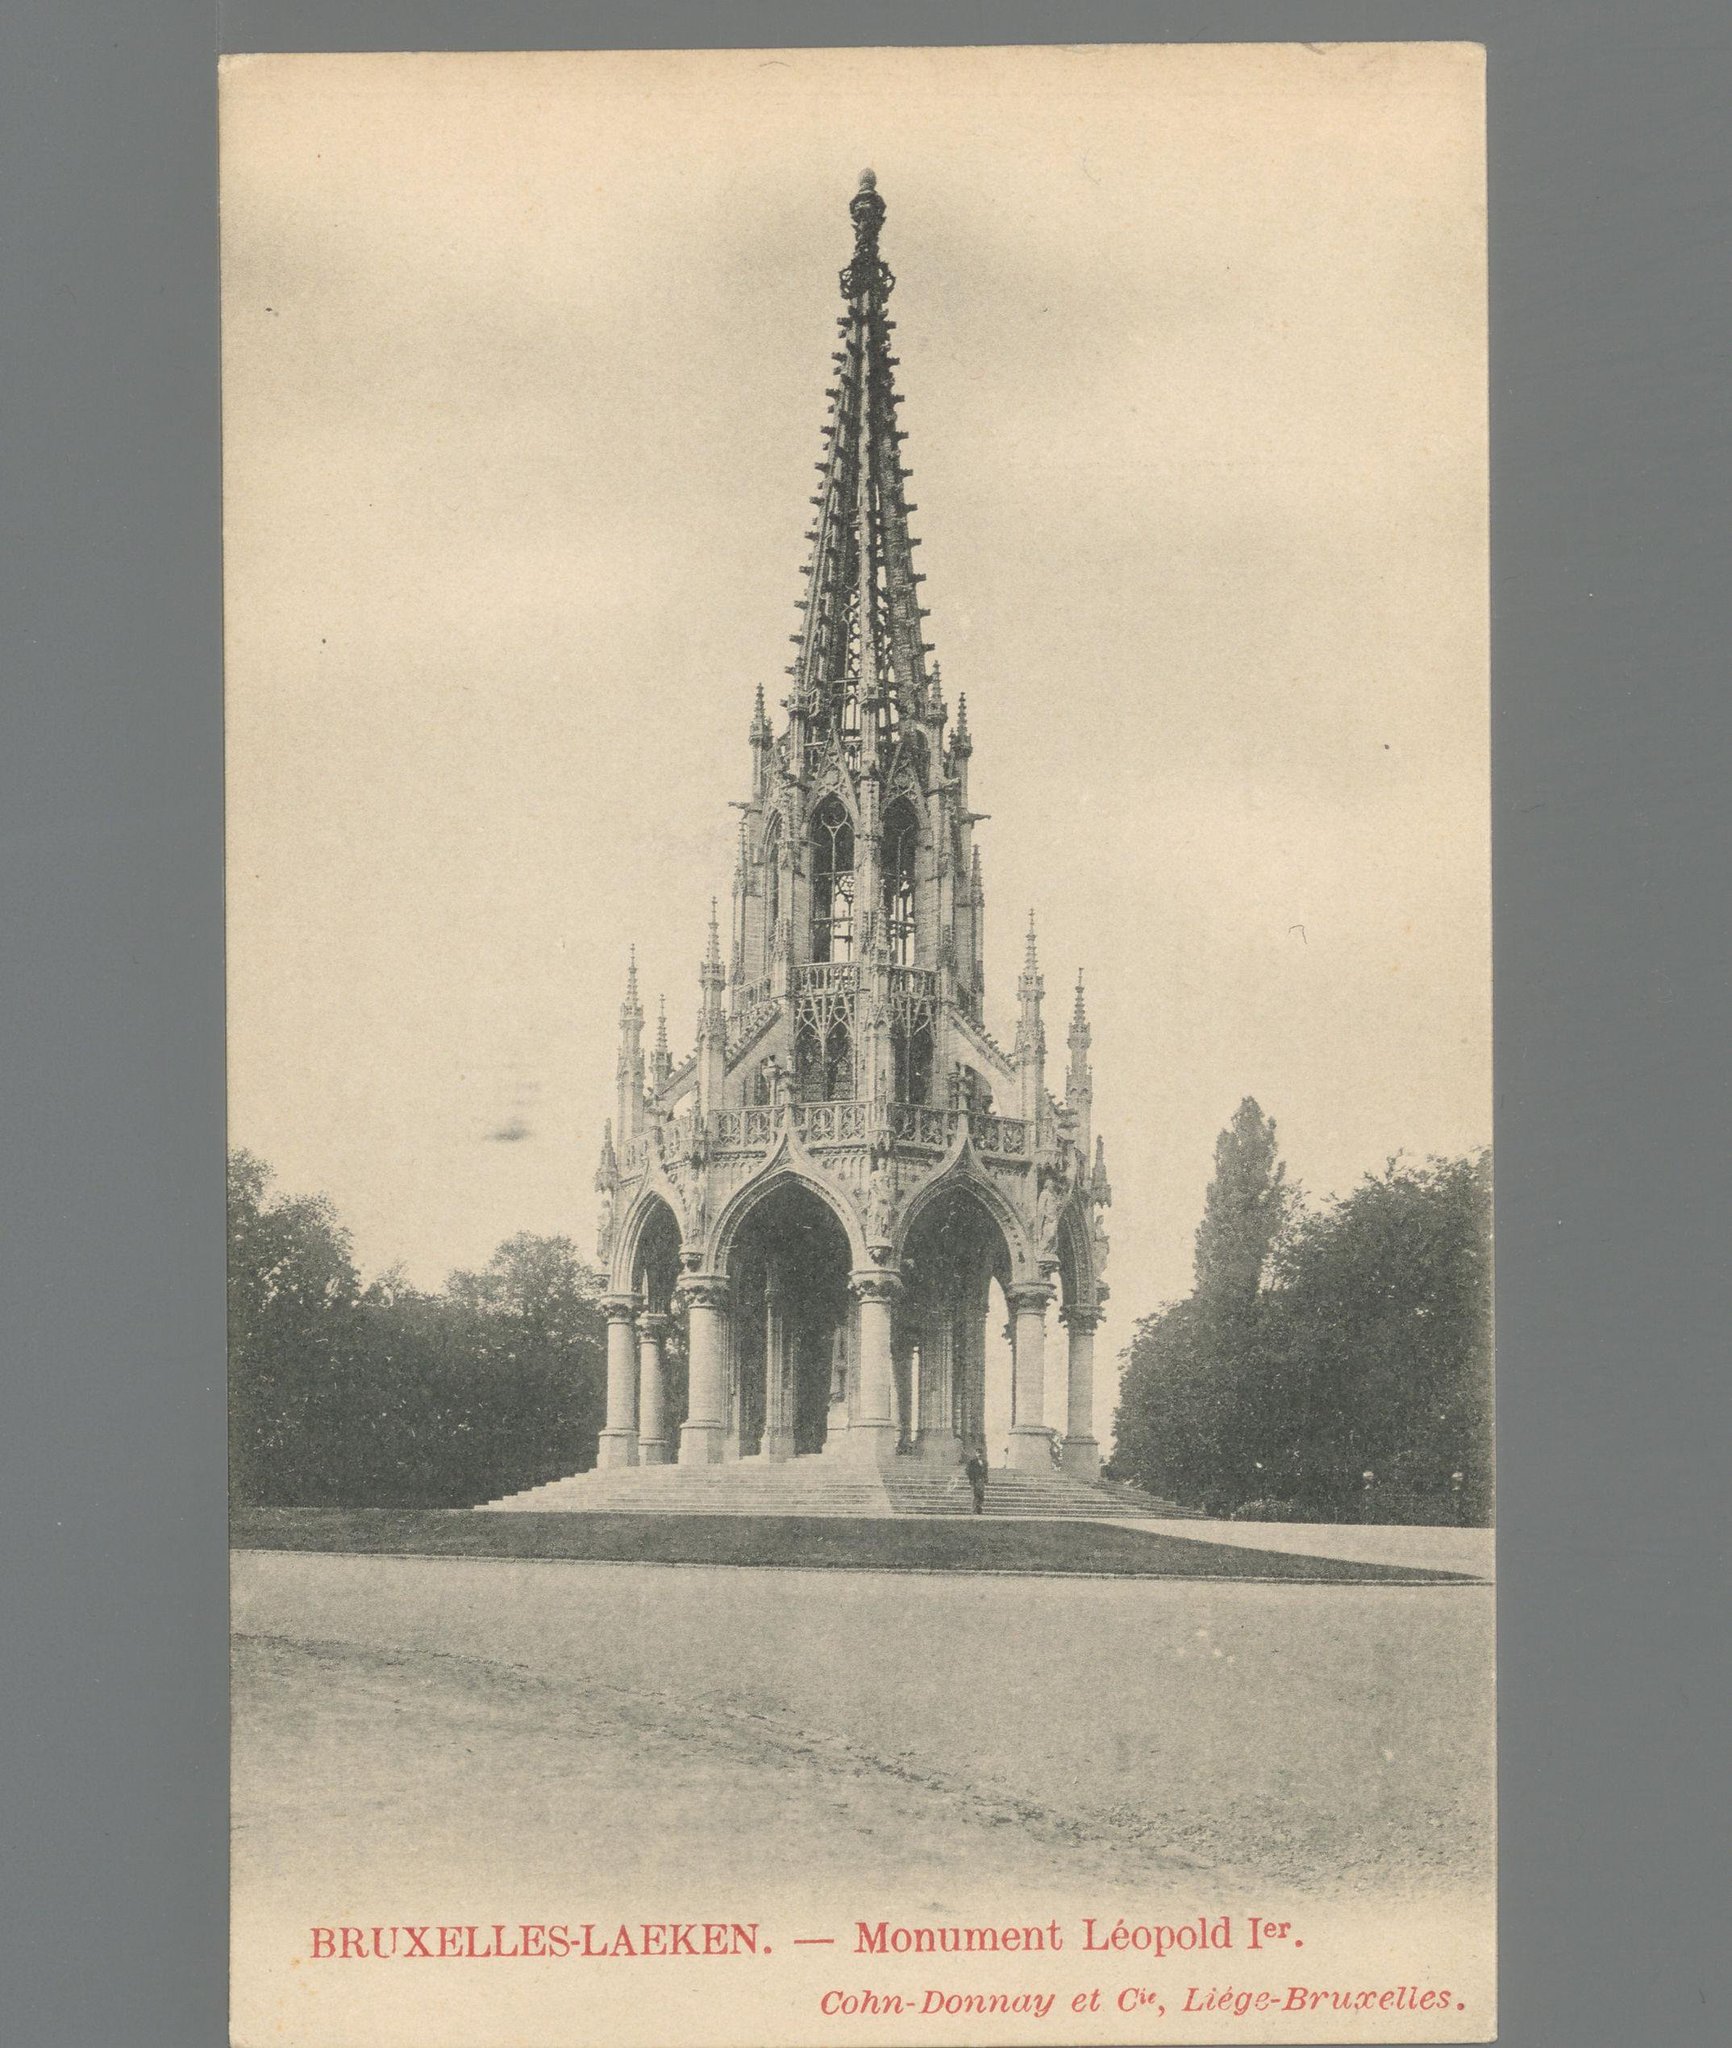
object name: photomechanical print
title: Bruxelles-Laeken. Monument Léopold Ier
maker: Anonymous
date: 1903-1906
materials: cardboard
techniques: photograph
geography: liège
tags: park, monument, statue, laeken